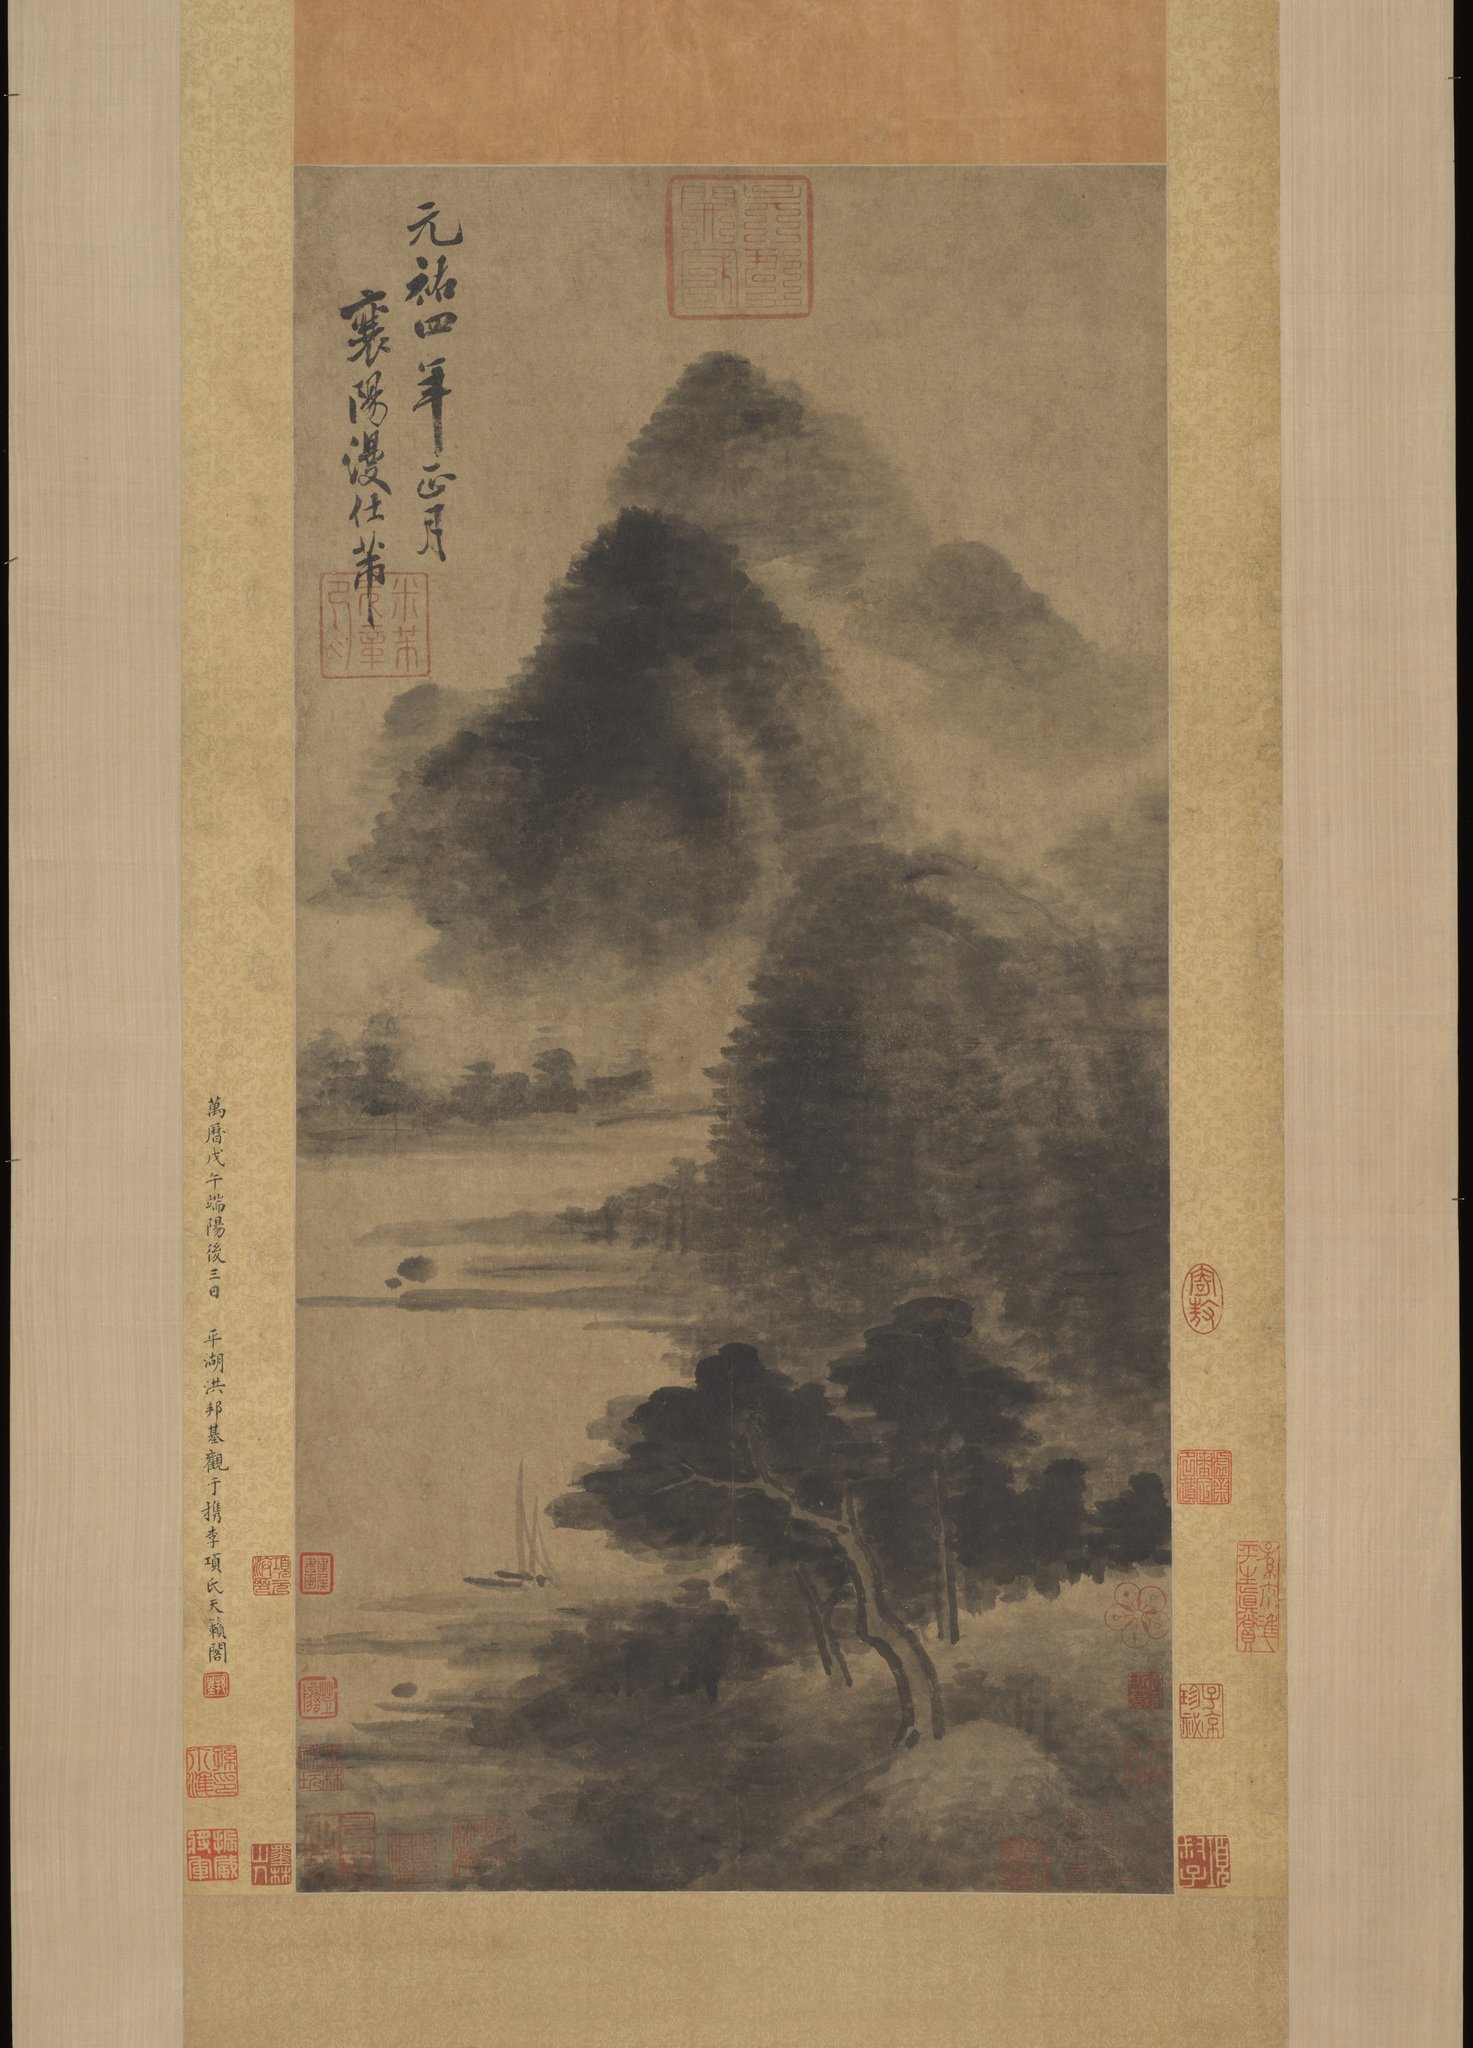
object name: hanging scroll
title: Landscape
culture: chinese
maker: unidentified artist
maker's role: artist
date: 1368-1911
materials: silk